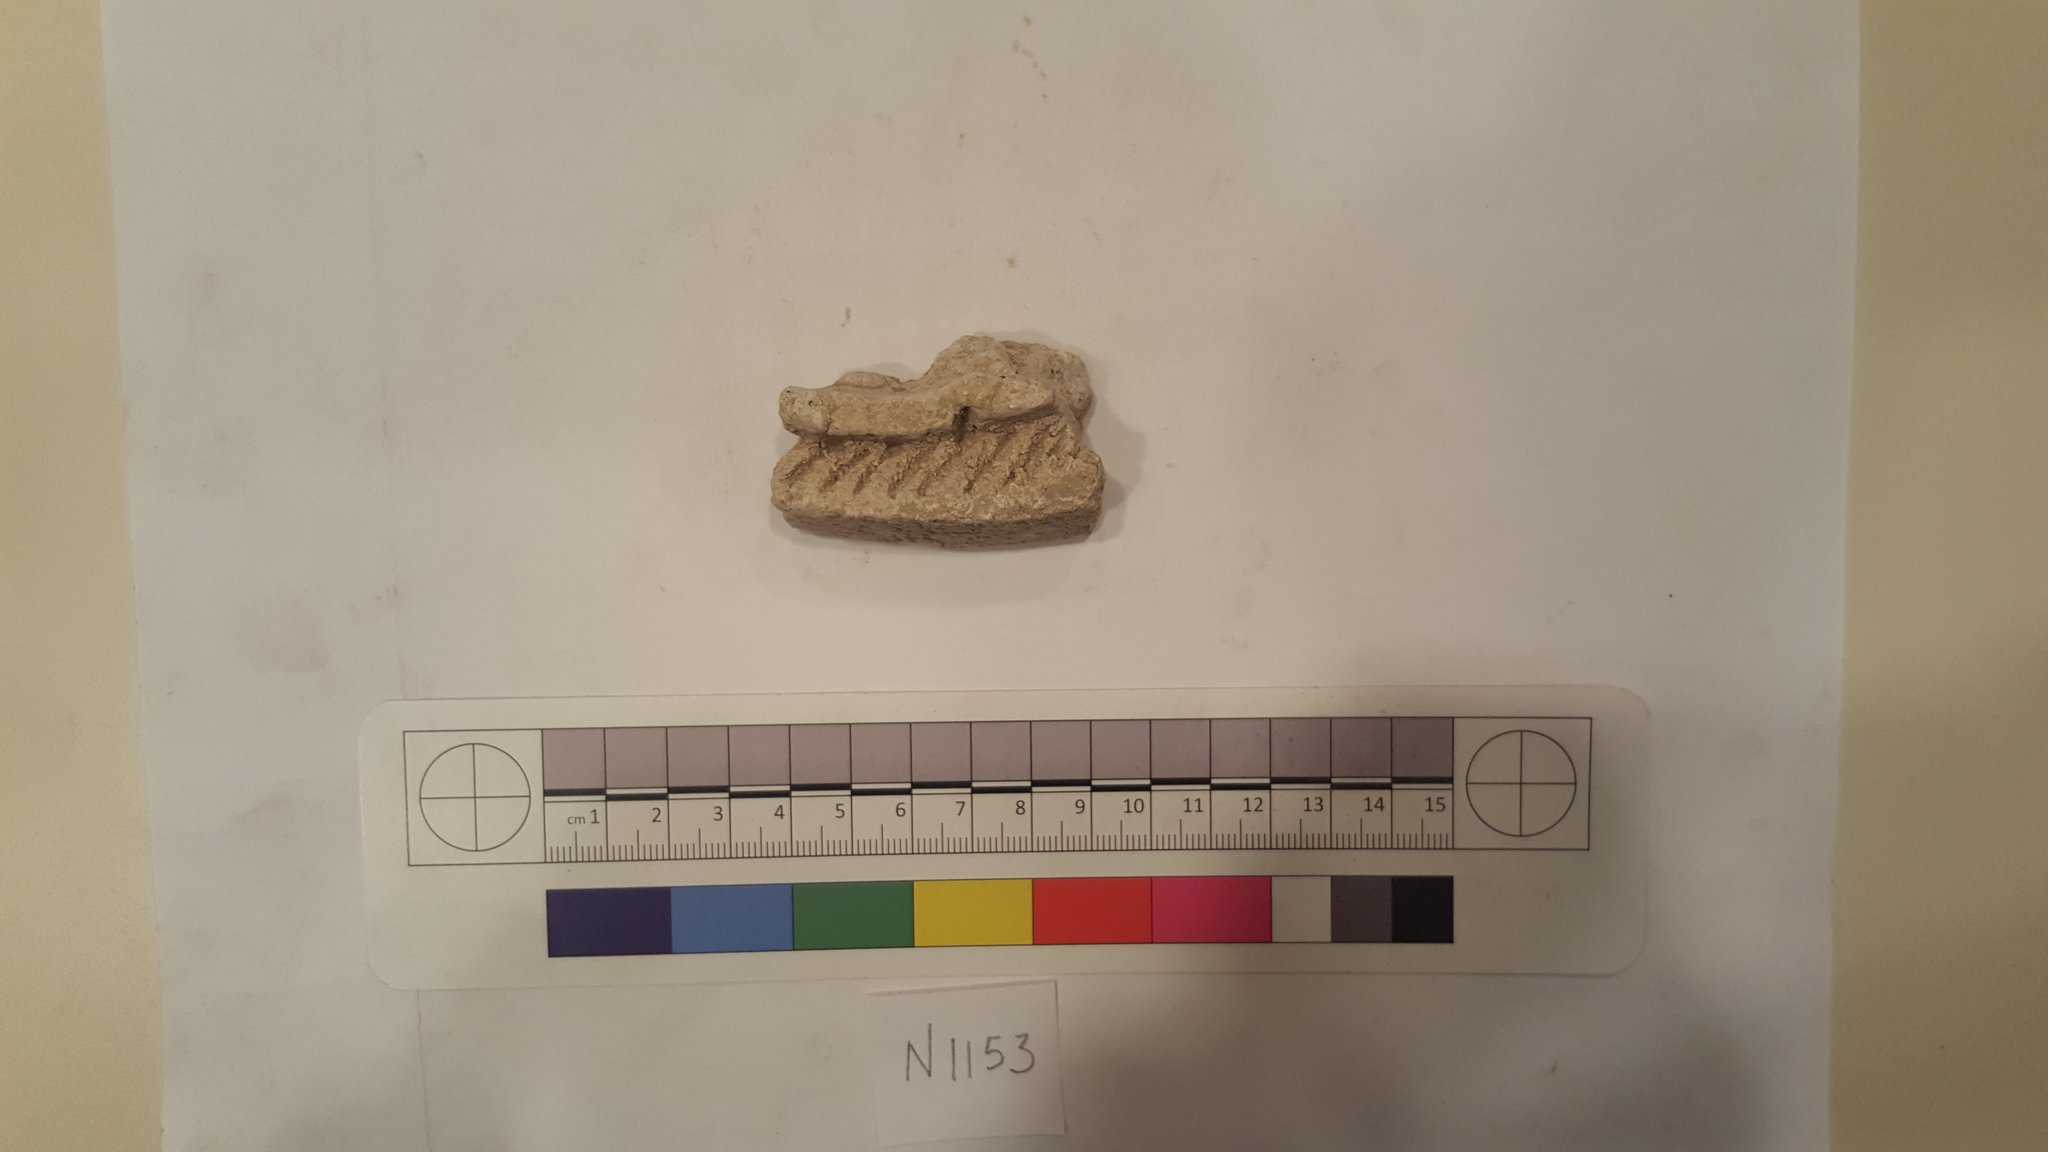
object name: fragment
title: Stucco Fragment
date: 701-1200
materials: plaster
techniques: carving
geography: iran